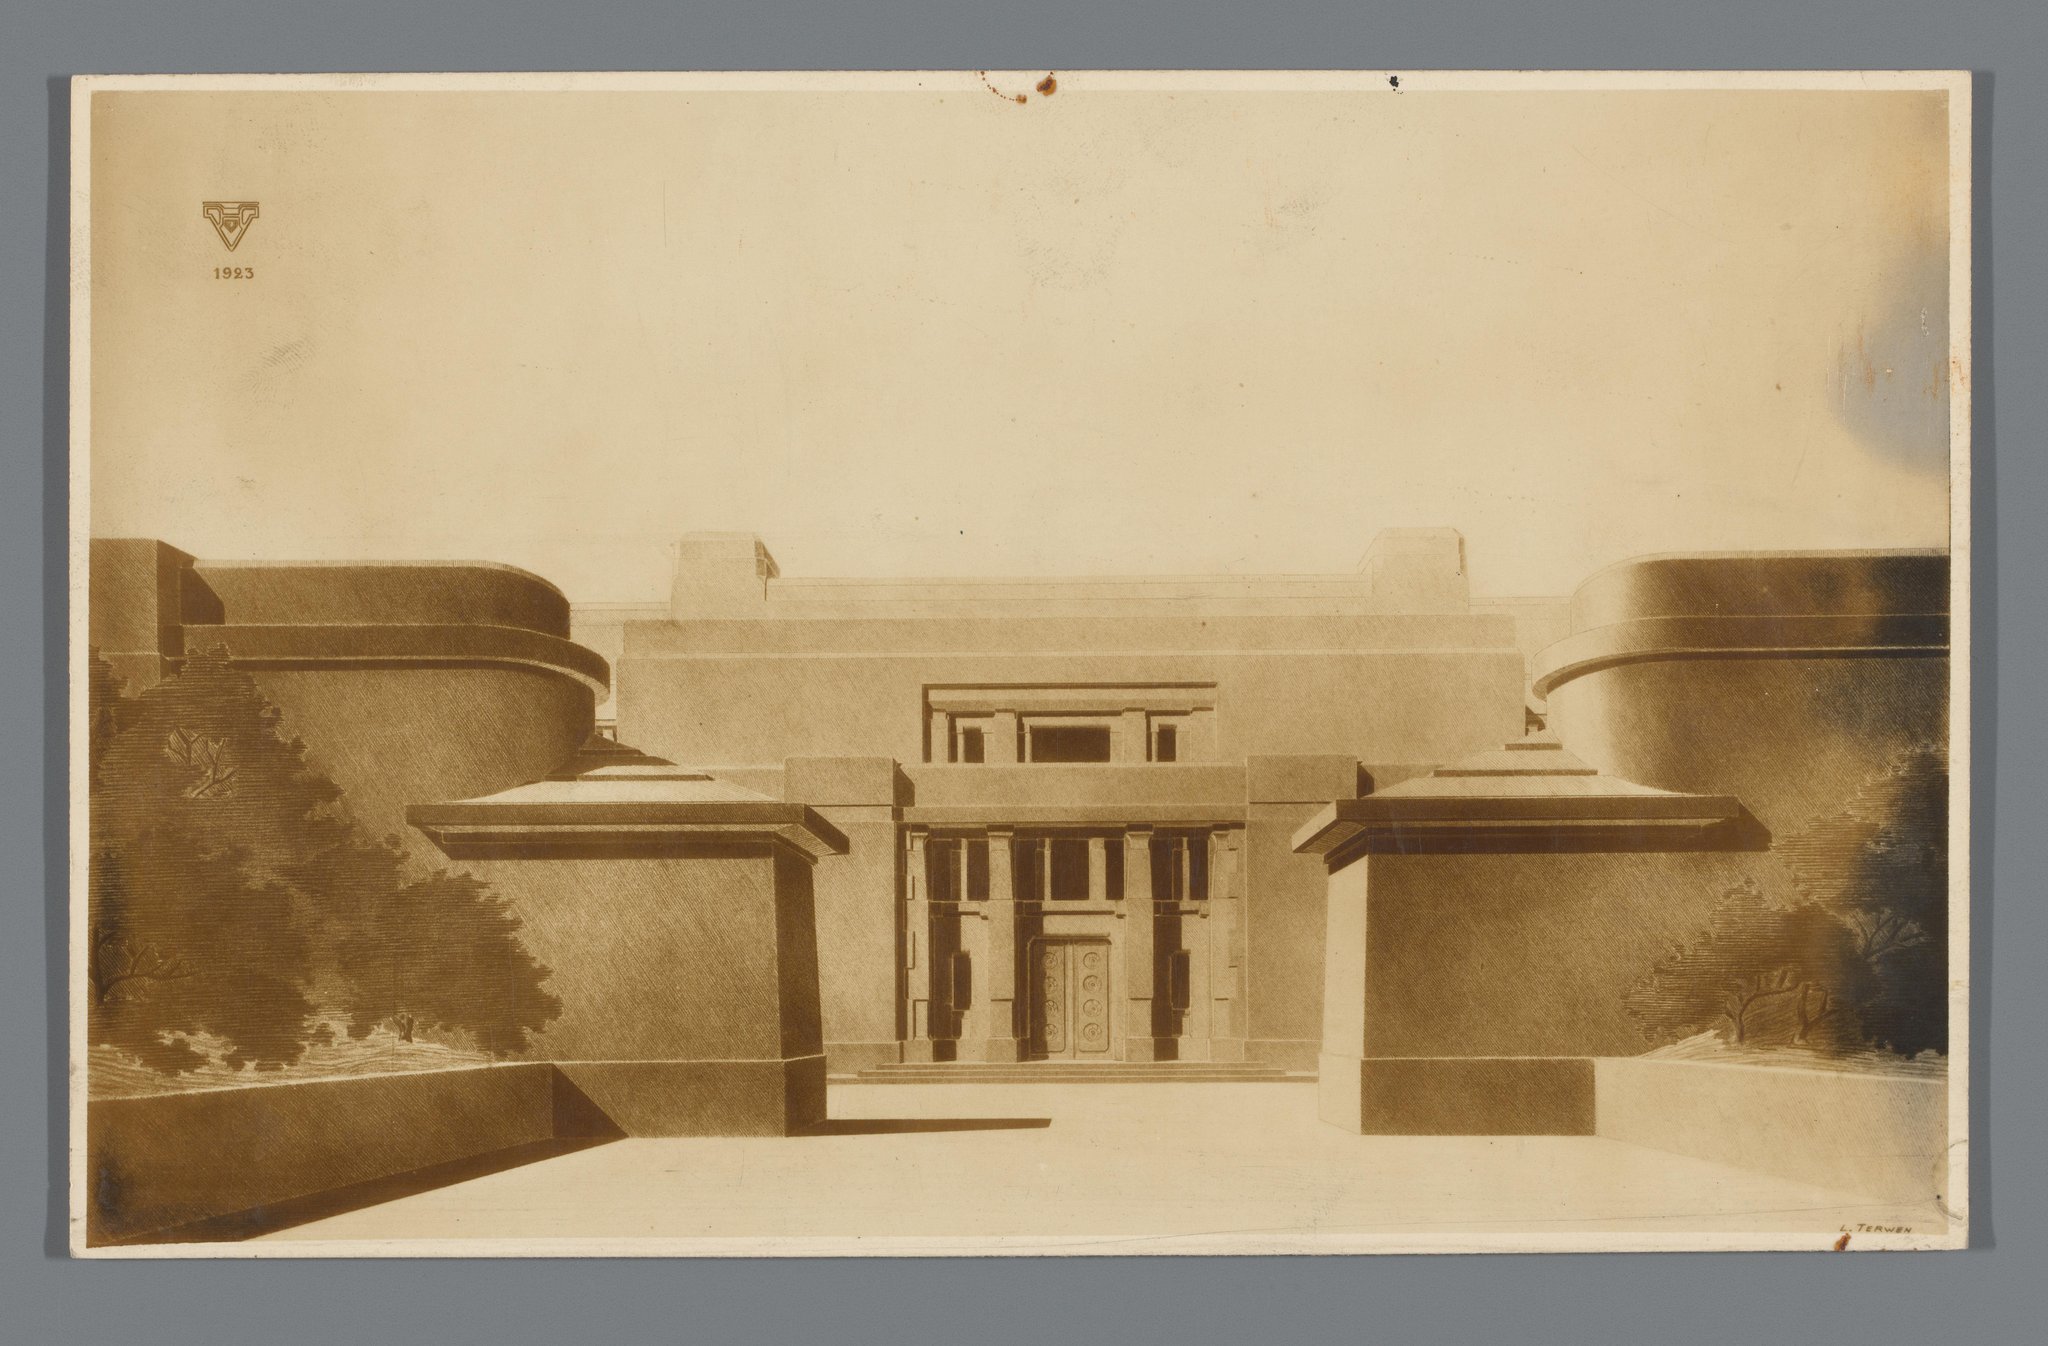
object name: photograph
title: België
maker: adam frequin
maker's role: fotograaf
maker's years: 1883-1939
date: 1923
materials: photographic support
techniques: gelatin silver print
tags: belgium